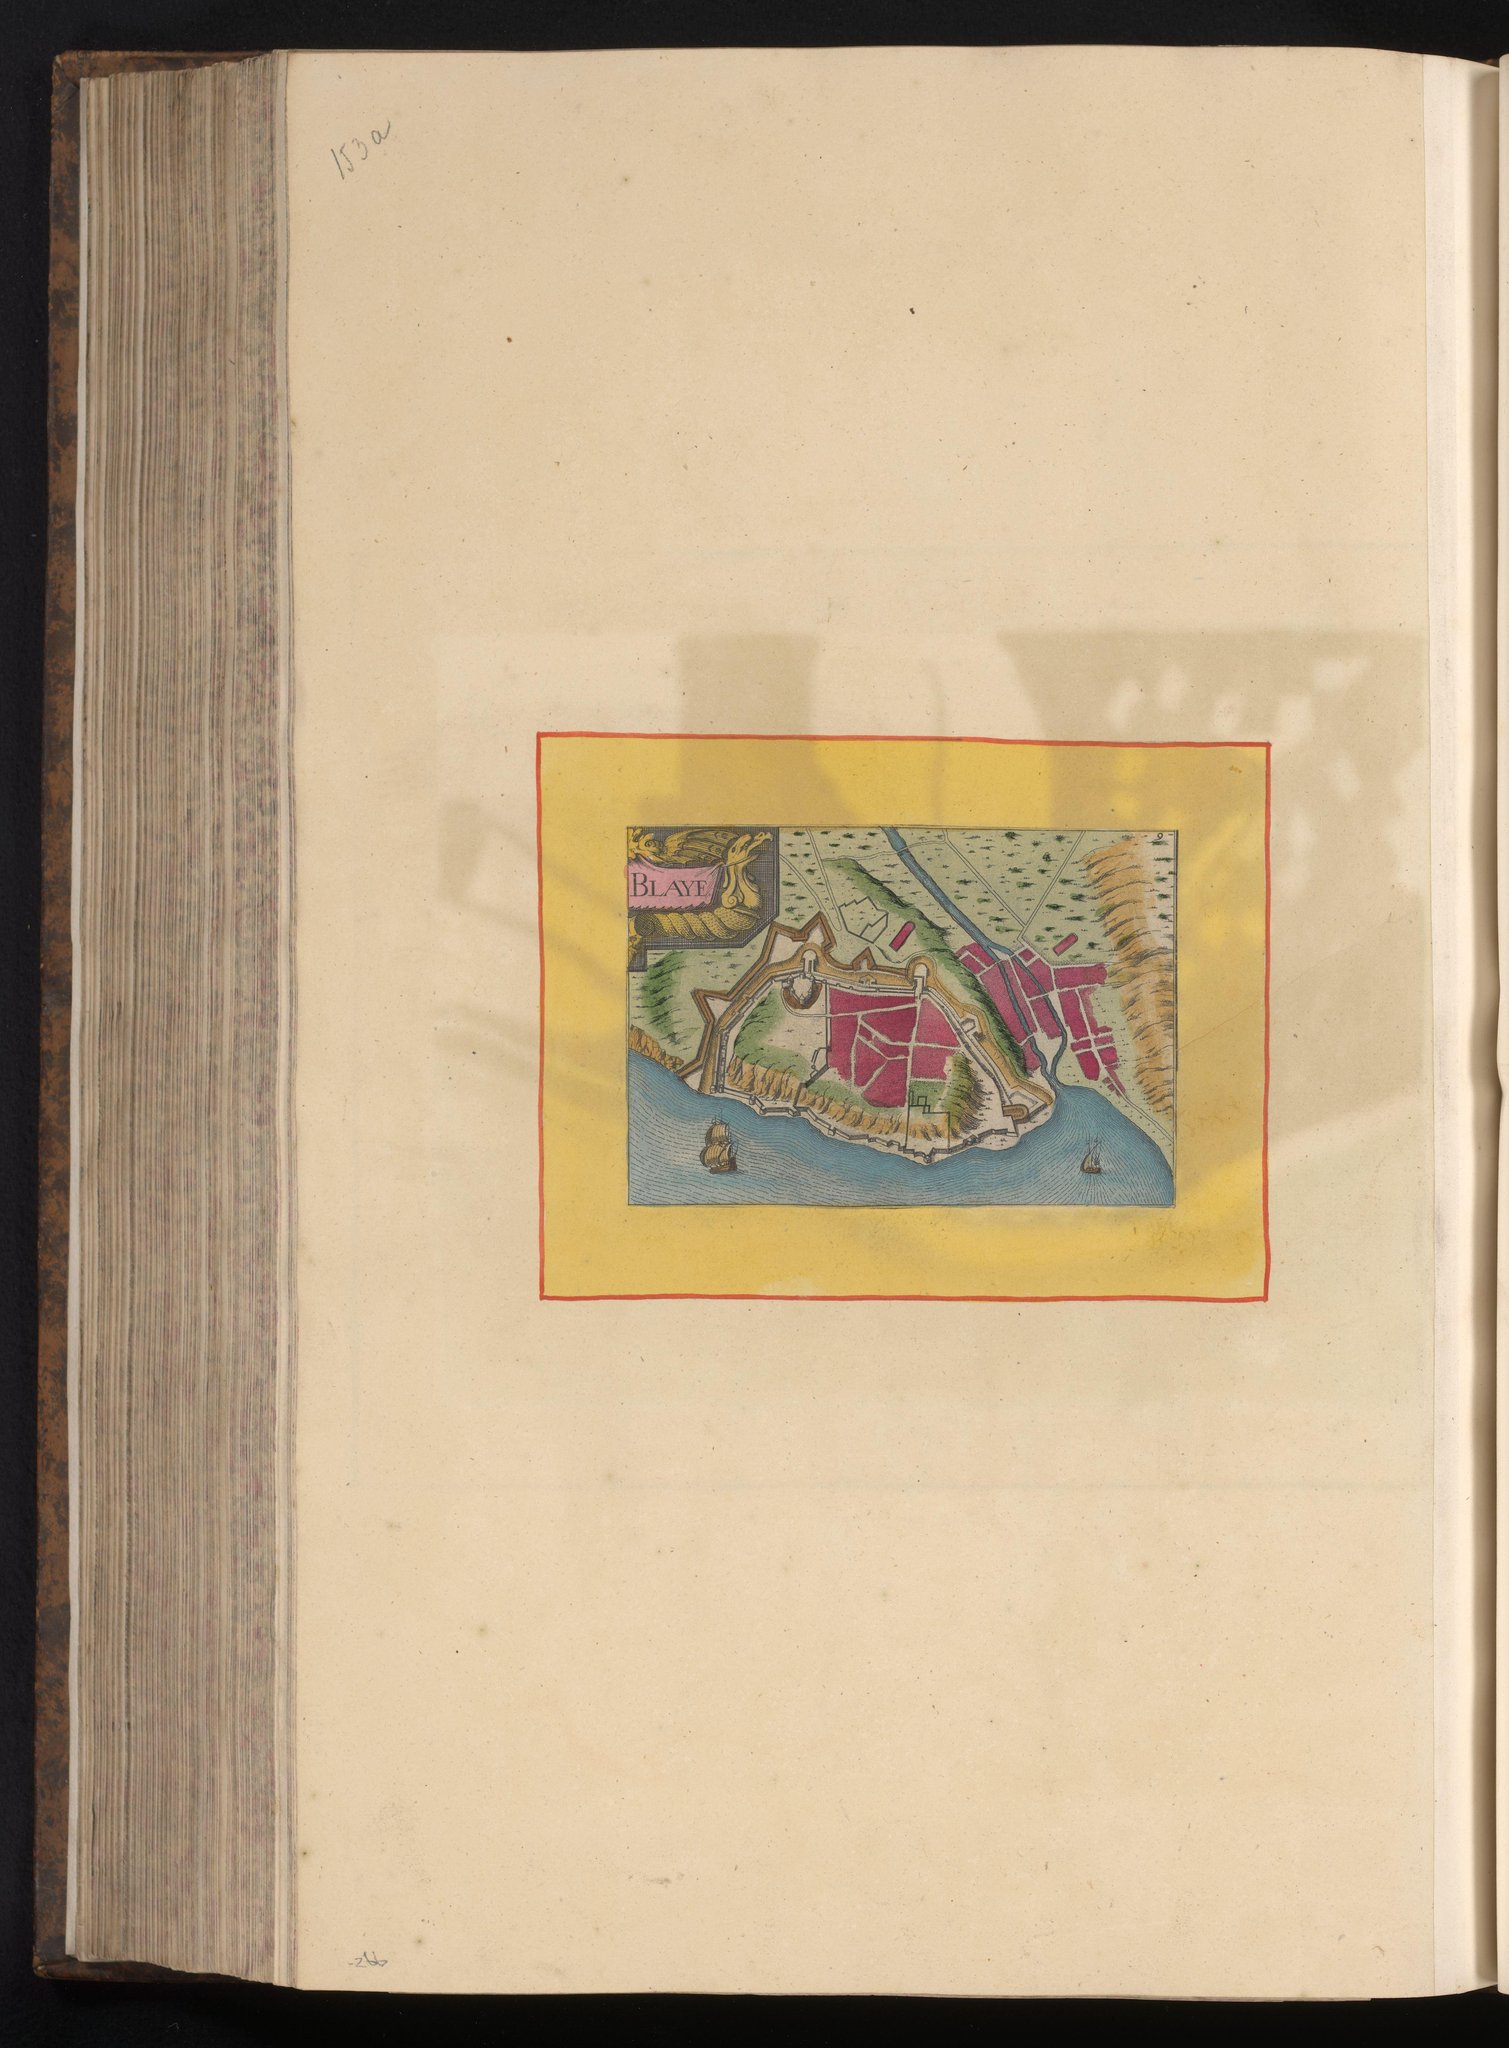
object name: print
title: Plattegrond van Blaye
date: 1638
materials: paper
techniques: engraving, etching, hand coloring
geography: paris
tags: maps of cities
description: Prent uit: Tassin, Christophe. Les plans et profils de toutes les principales villes et lieux considérables de France (...). Parijs: Michel van Lochom, 1638, kaart 9 uit het deel 'Guyenne'.